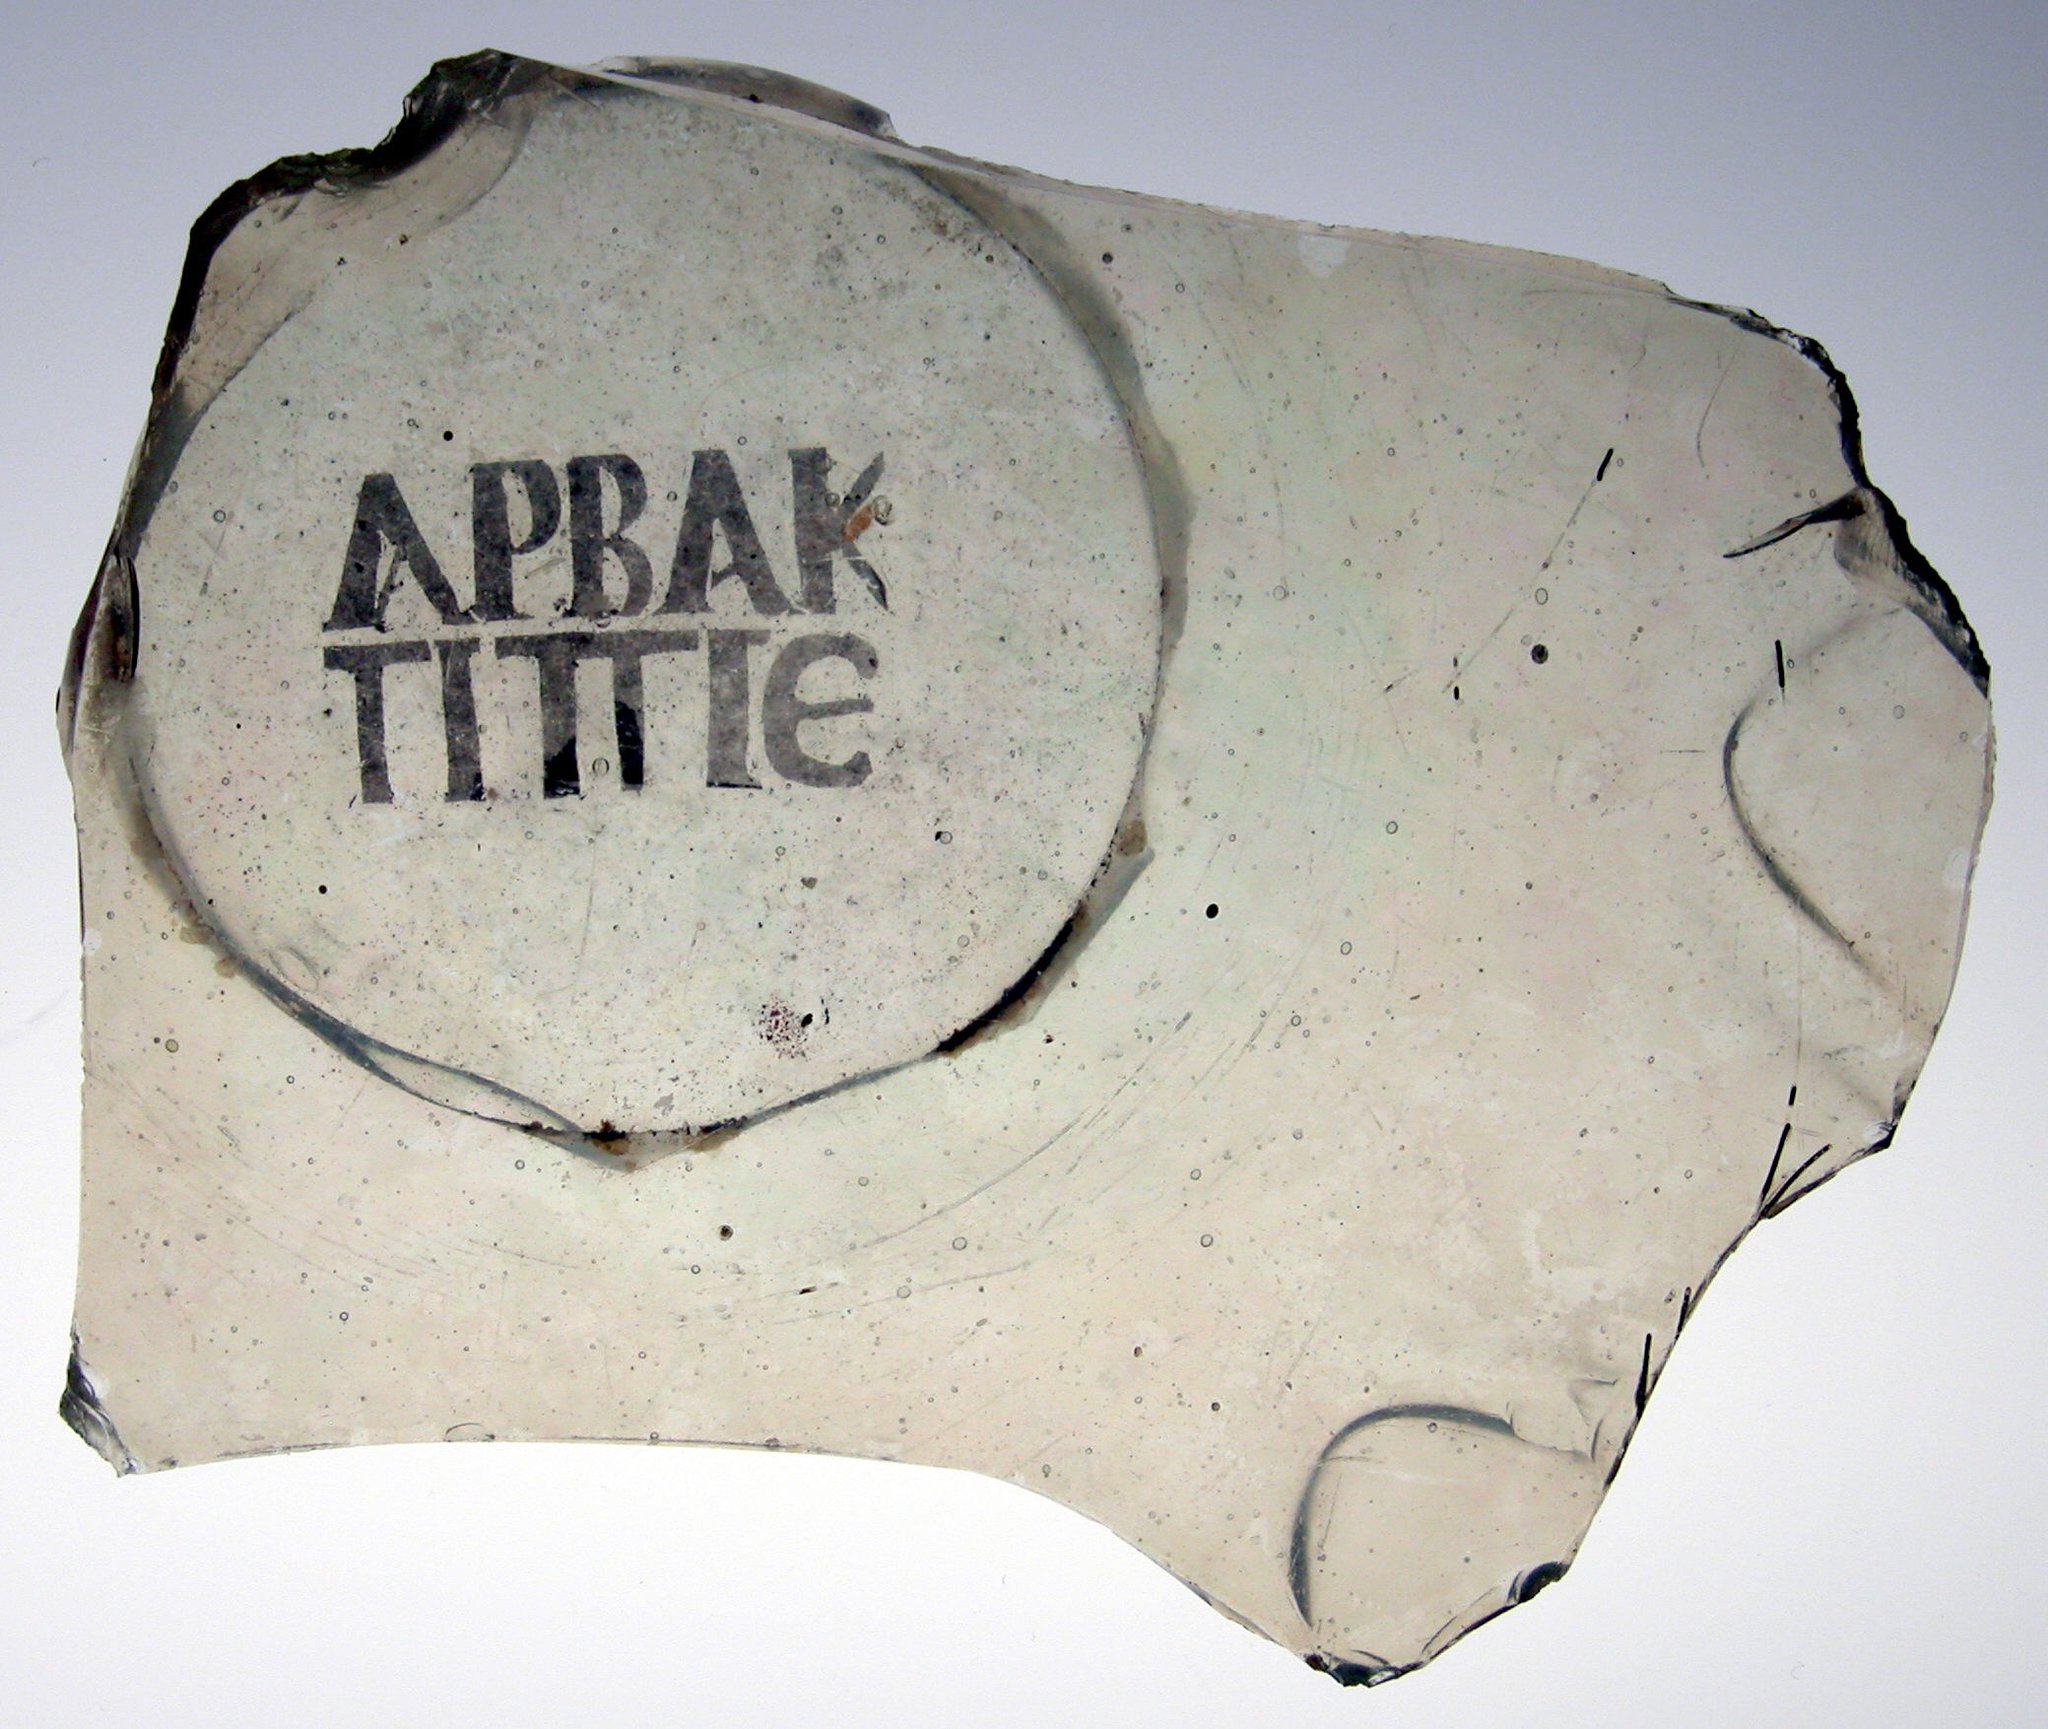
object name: fragment of a bowl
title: Fragment of a Glass Bowl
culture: roman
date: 201-300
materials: glass, gold leaf